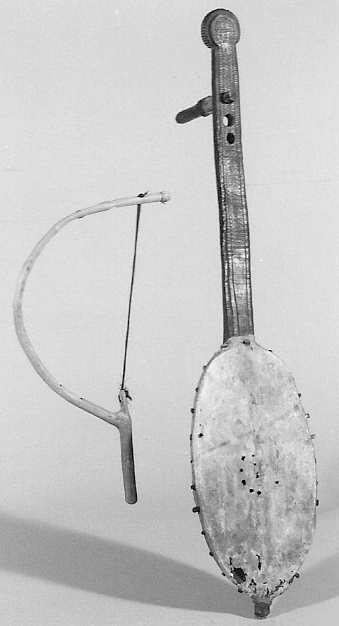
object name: gusle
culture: eastern european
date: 1850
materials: skin, wood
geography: croatia